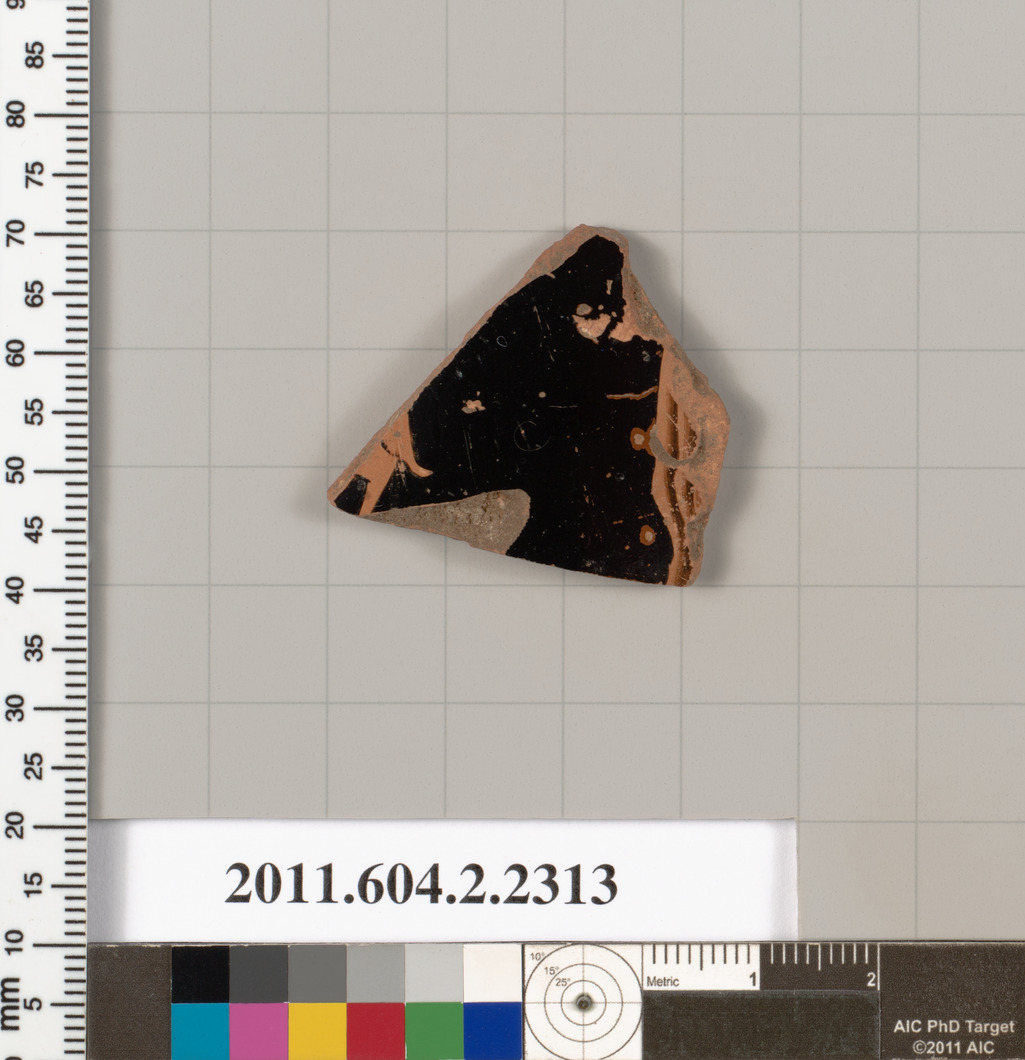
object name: pot fragment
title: Terracotta fragment of a pot; unglazed on the inside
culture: greek, attic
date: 475-451 BCE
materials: terracotta